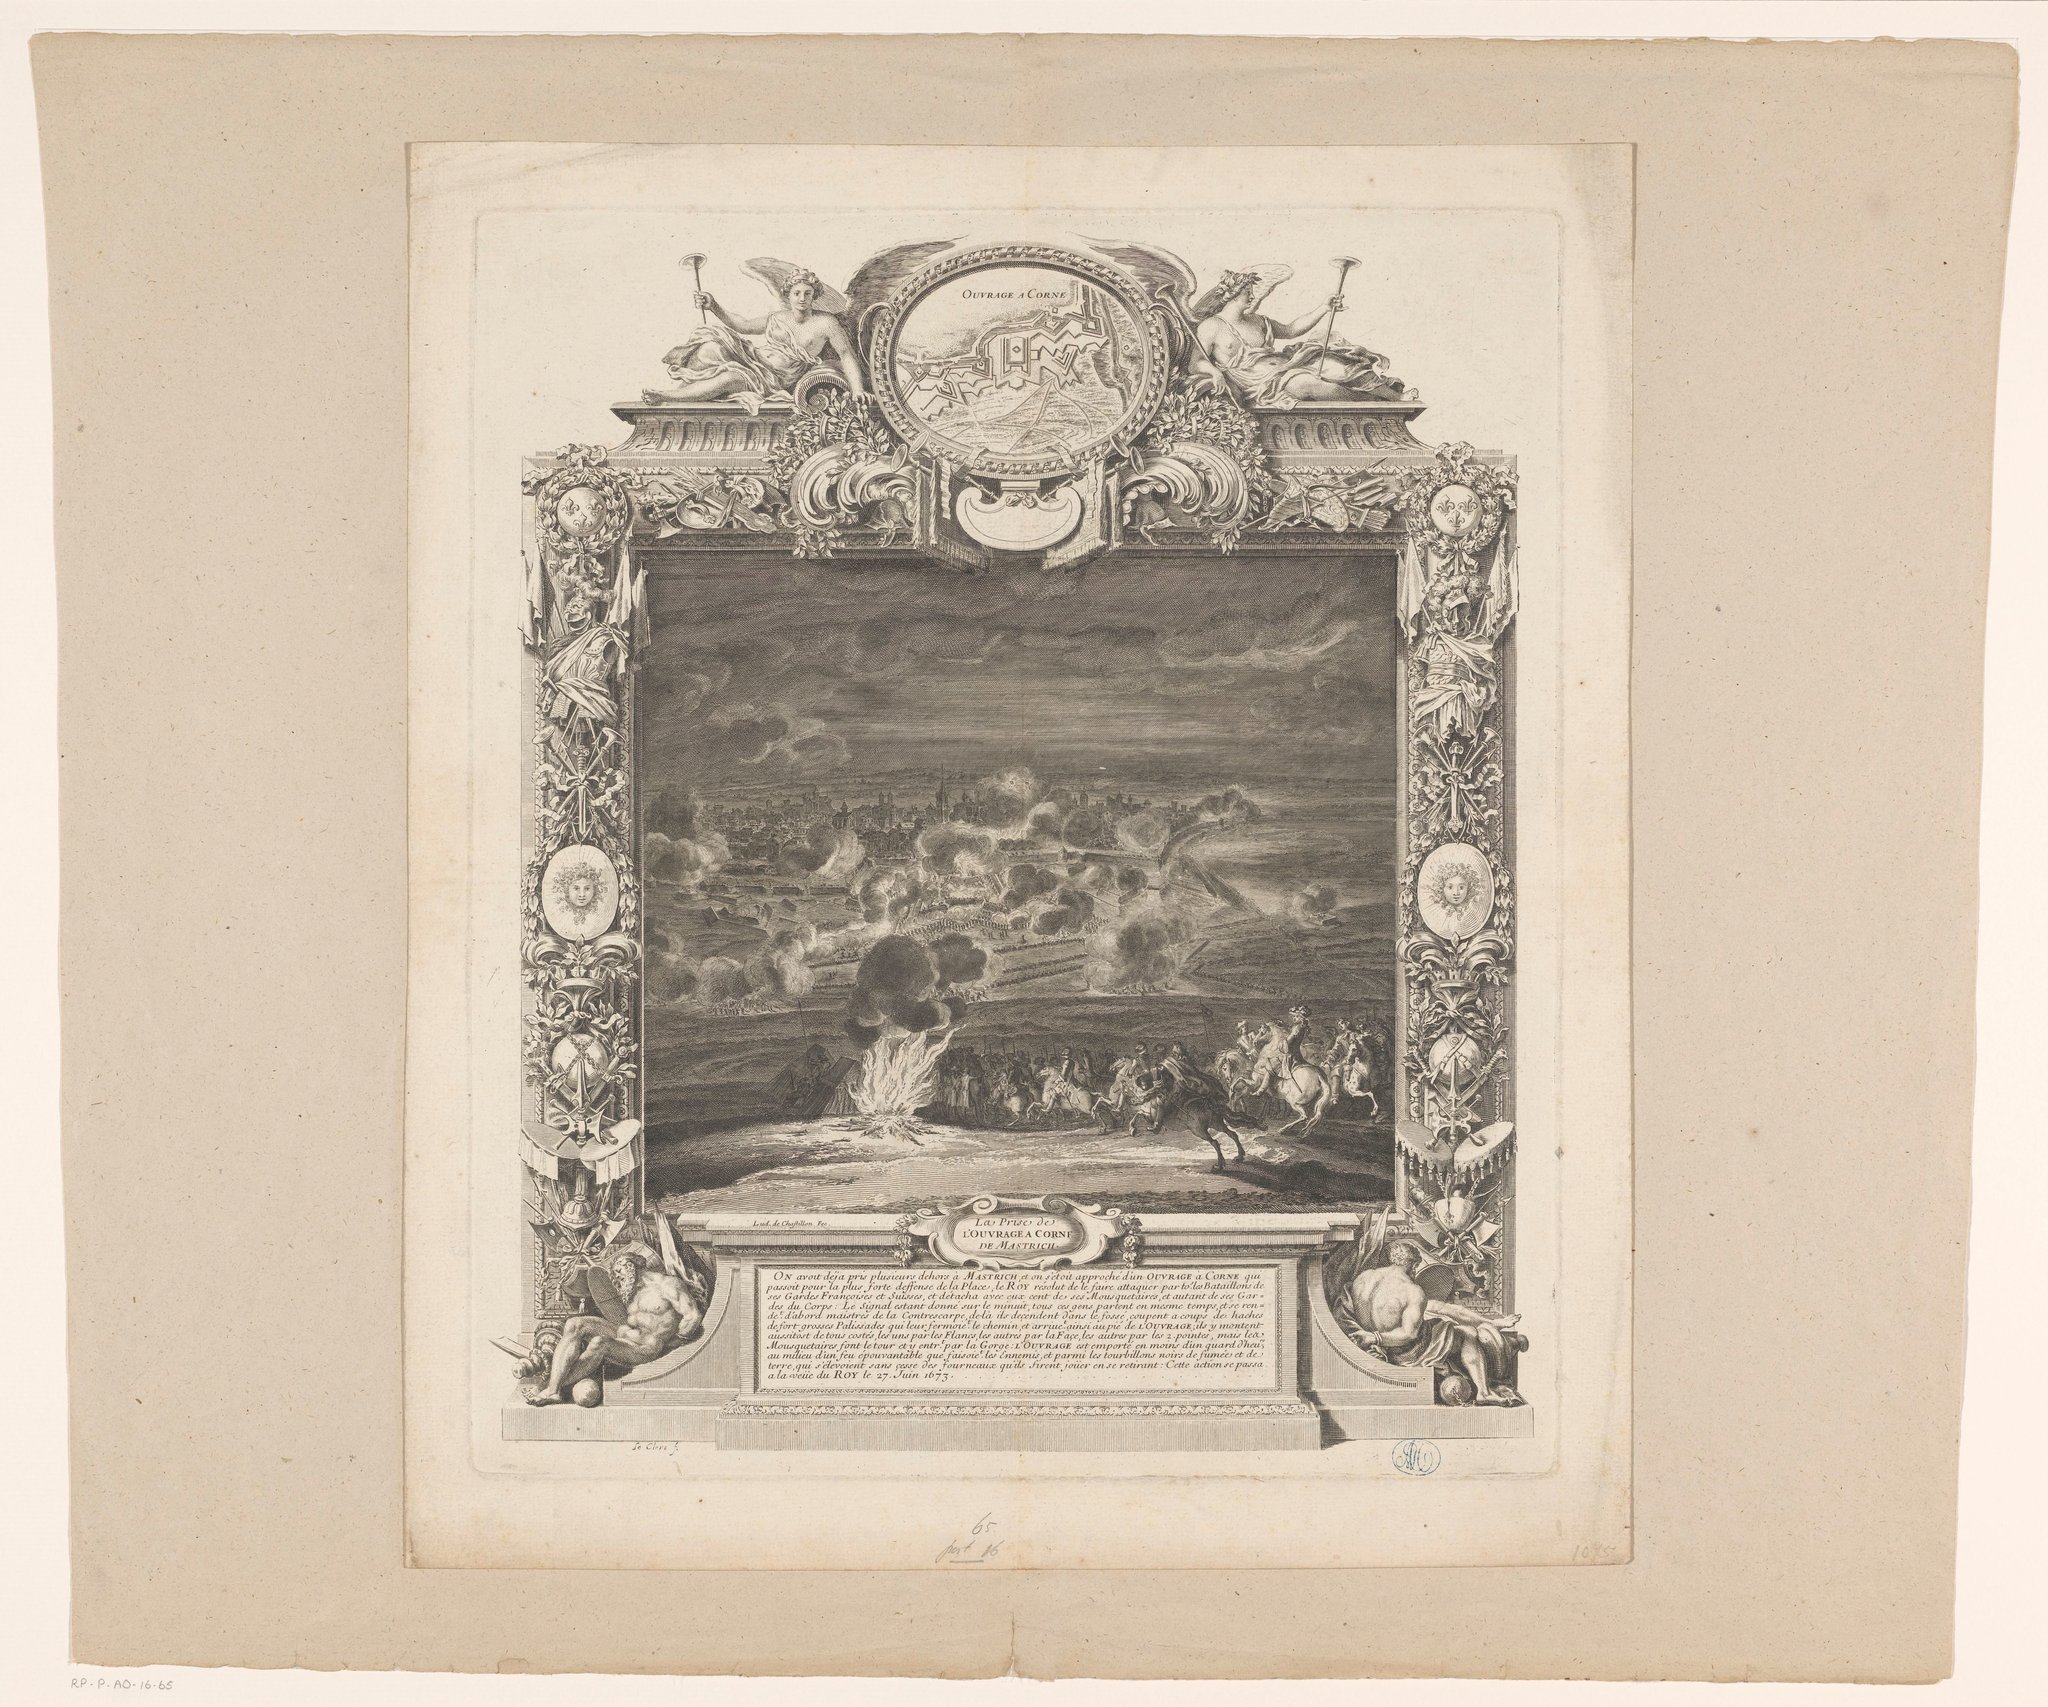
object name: print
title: Verovering van een bolwerk van Maastricht door de Fransen op 30 juni 1673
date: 1683-1694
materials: paper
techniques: engraving, etching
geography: paris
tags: lodewijk xiv (koning van frankrijk), capture of city (after the siege), maastricht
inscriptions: collector's mark: Lugt 195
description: Verovering van een bolwerk van Maastricht door de Franse legers op 30 juni 1673. De prent maakt deel uit van een Franse reeks van 28 prenten met de veroveringen van de Franse koning Lodewijk XIV tussen 1672 en 1678 getiteld: Grandes Conquêtes du Roi. In een ornamentele omlijsting met bovenaan een plattegrond van de versterkingen van de stad, verder wapens, delen van wapenrustingen en geboeide gevangenen. Onderaan een cartouche met opschrift van 11 regels in het Frans.